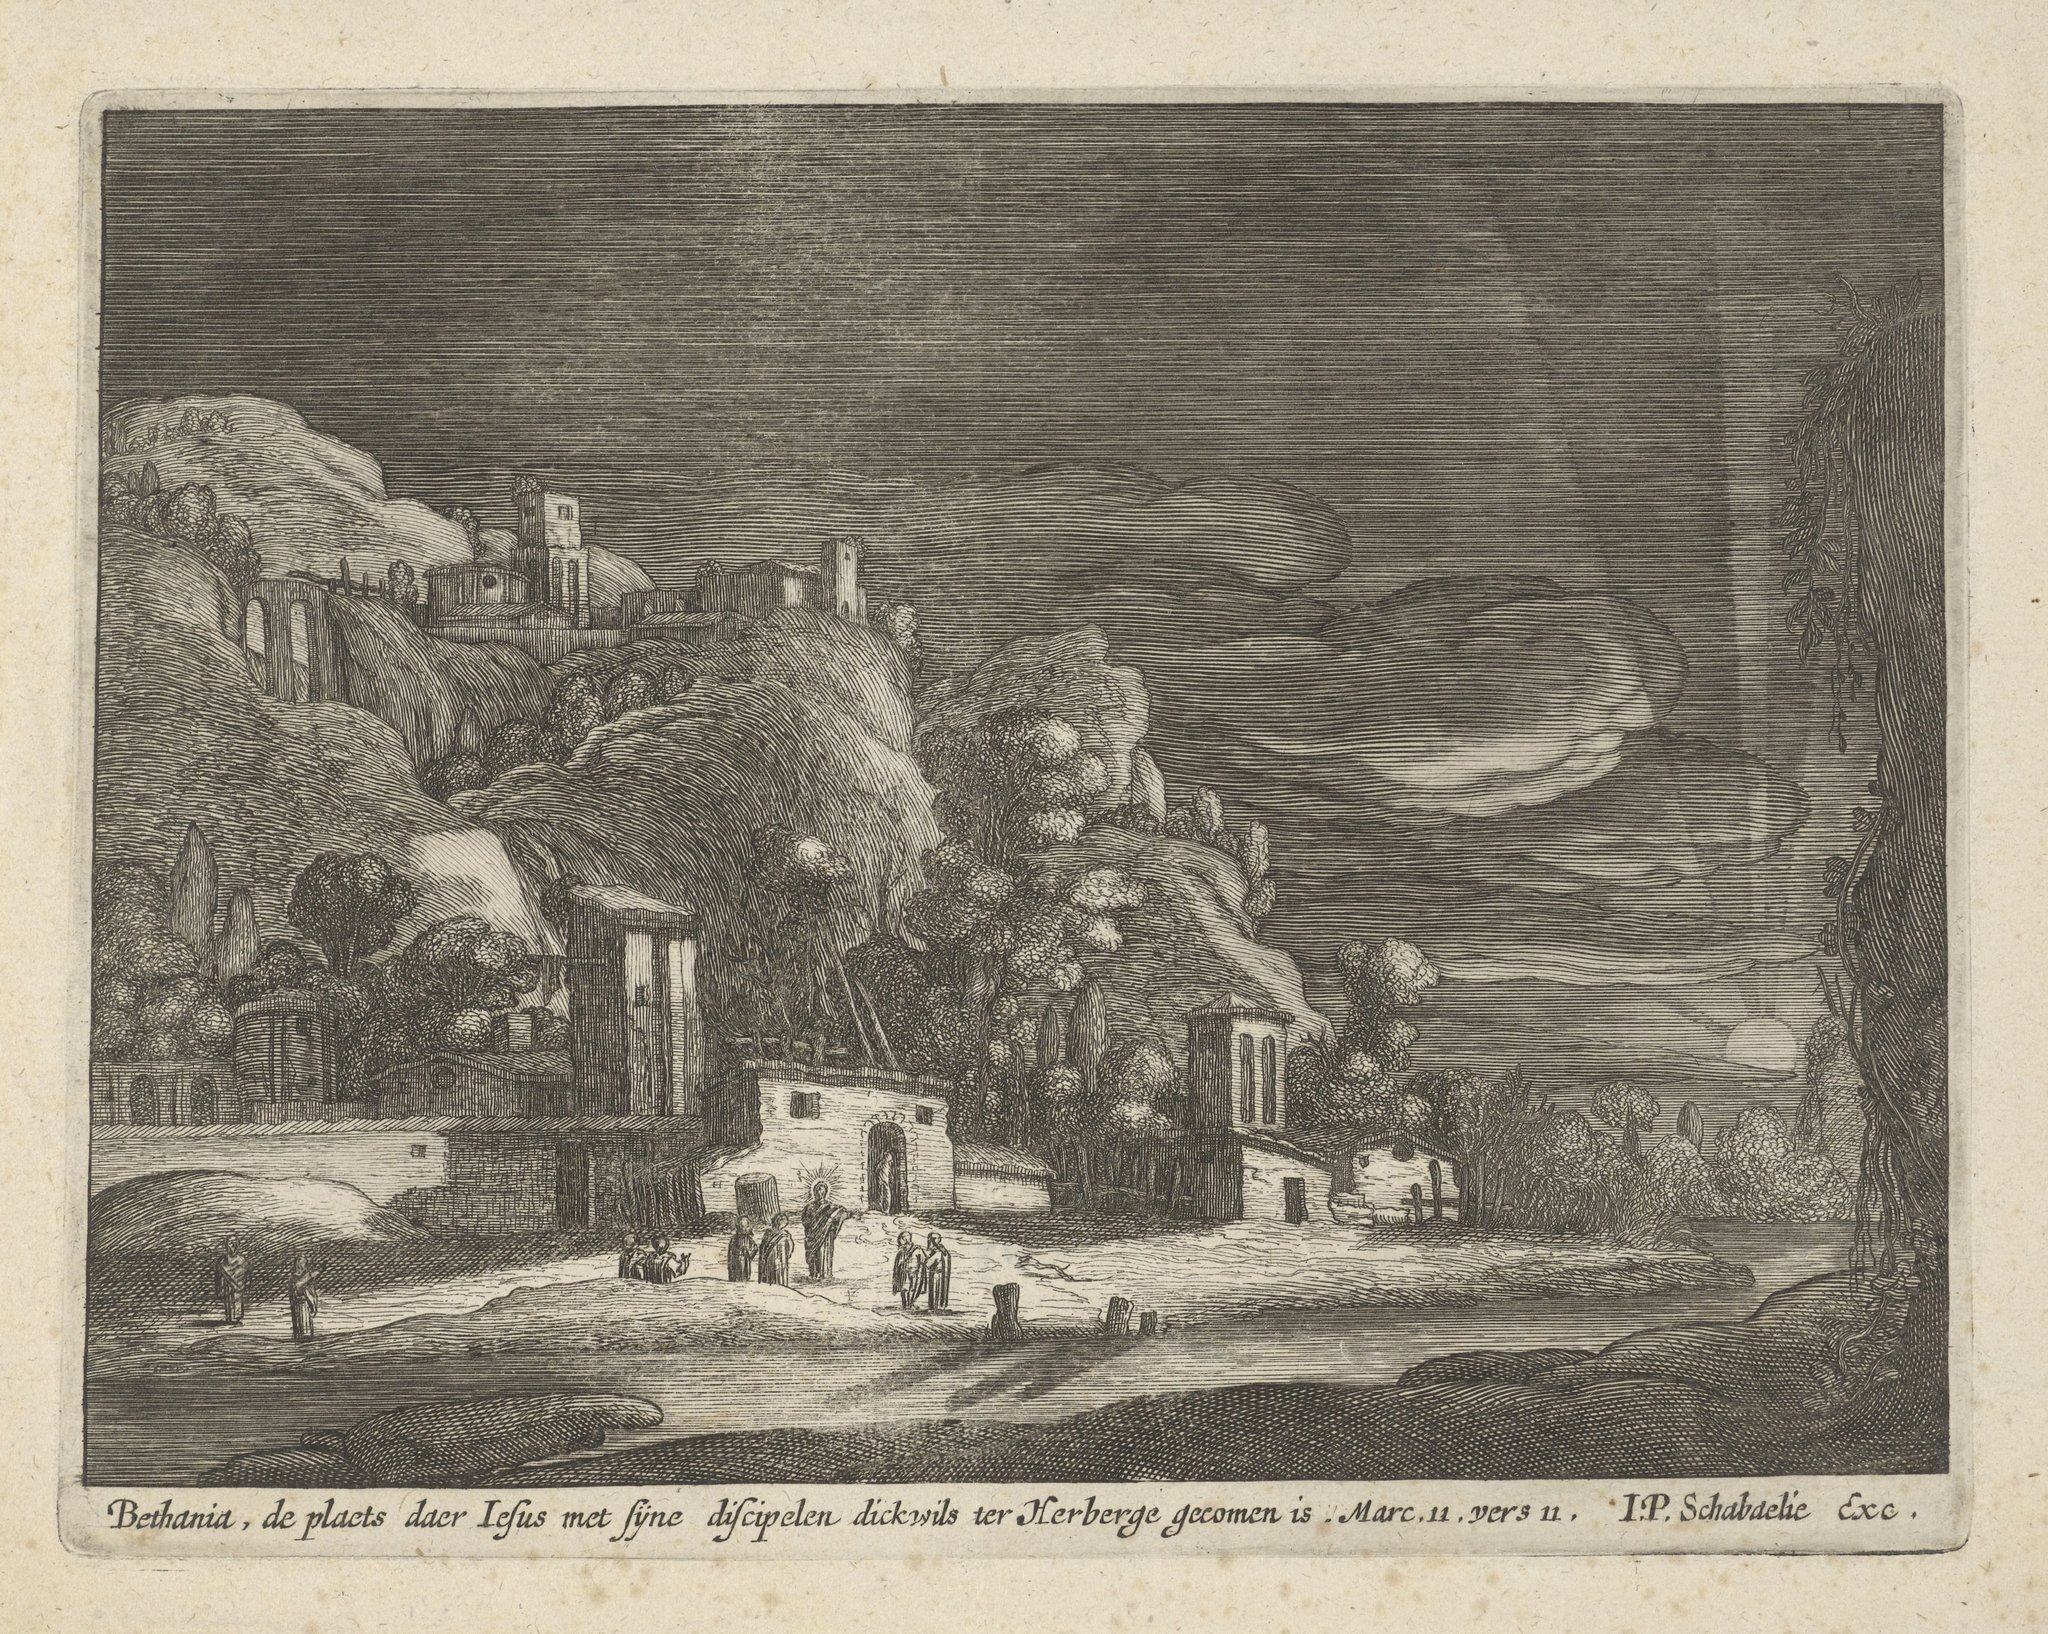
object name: print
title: Bethania, de plaets daer Iesus met syne discipelen dickwils ter Herberge gecomen is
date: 1648-1656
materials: paper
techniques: engraving, etching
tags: sunset, meal in bethany (at the house of simon the leper) (matthew 26:6-13; mark 14:3-9; john 12:1-11), (high) hill - hh - ideal landscapes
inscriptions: collector's mark: Lugt 964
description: Prent opgenomen in: Schabaelje, Jan Philipsz. Den grooten emblemata sacra, bestaande in meer dan vier hondert bybelsche figueren, soo des Ouden als des Nieuwen Testaments. Amsterdam: Tymon Houthaeck en Jan Philipsz Schabaelje, 1654.